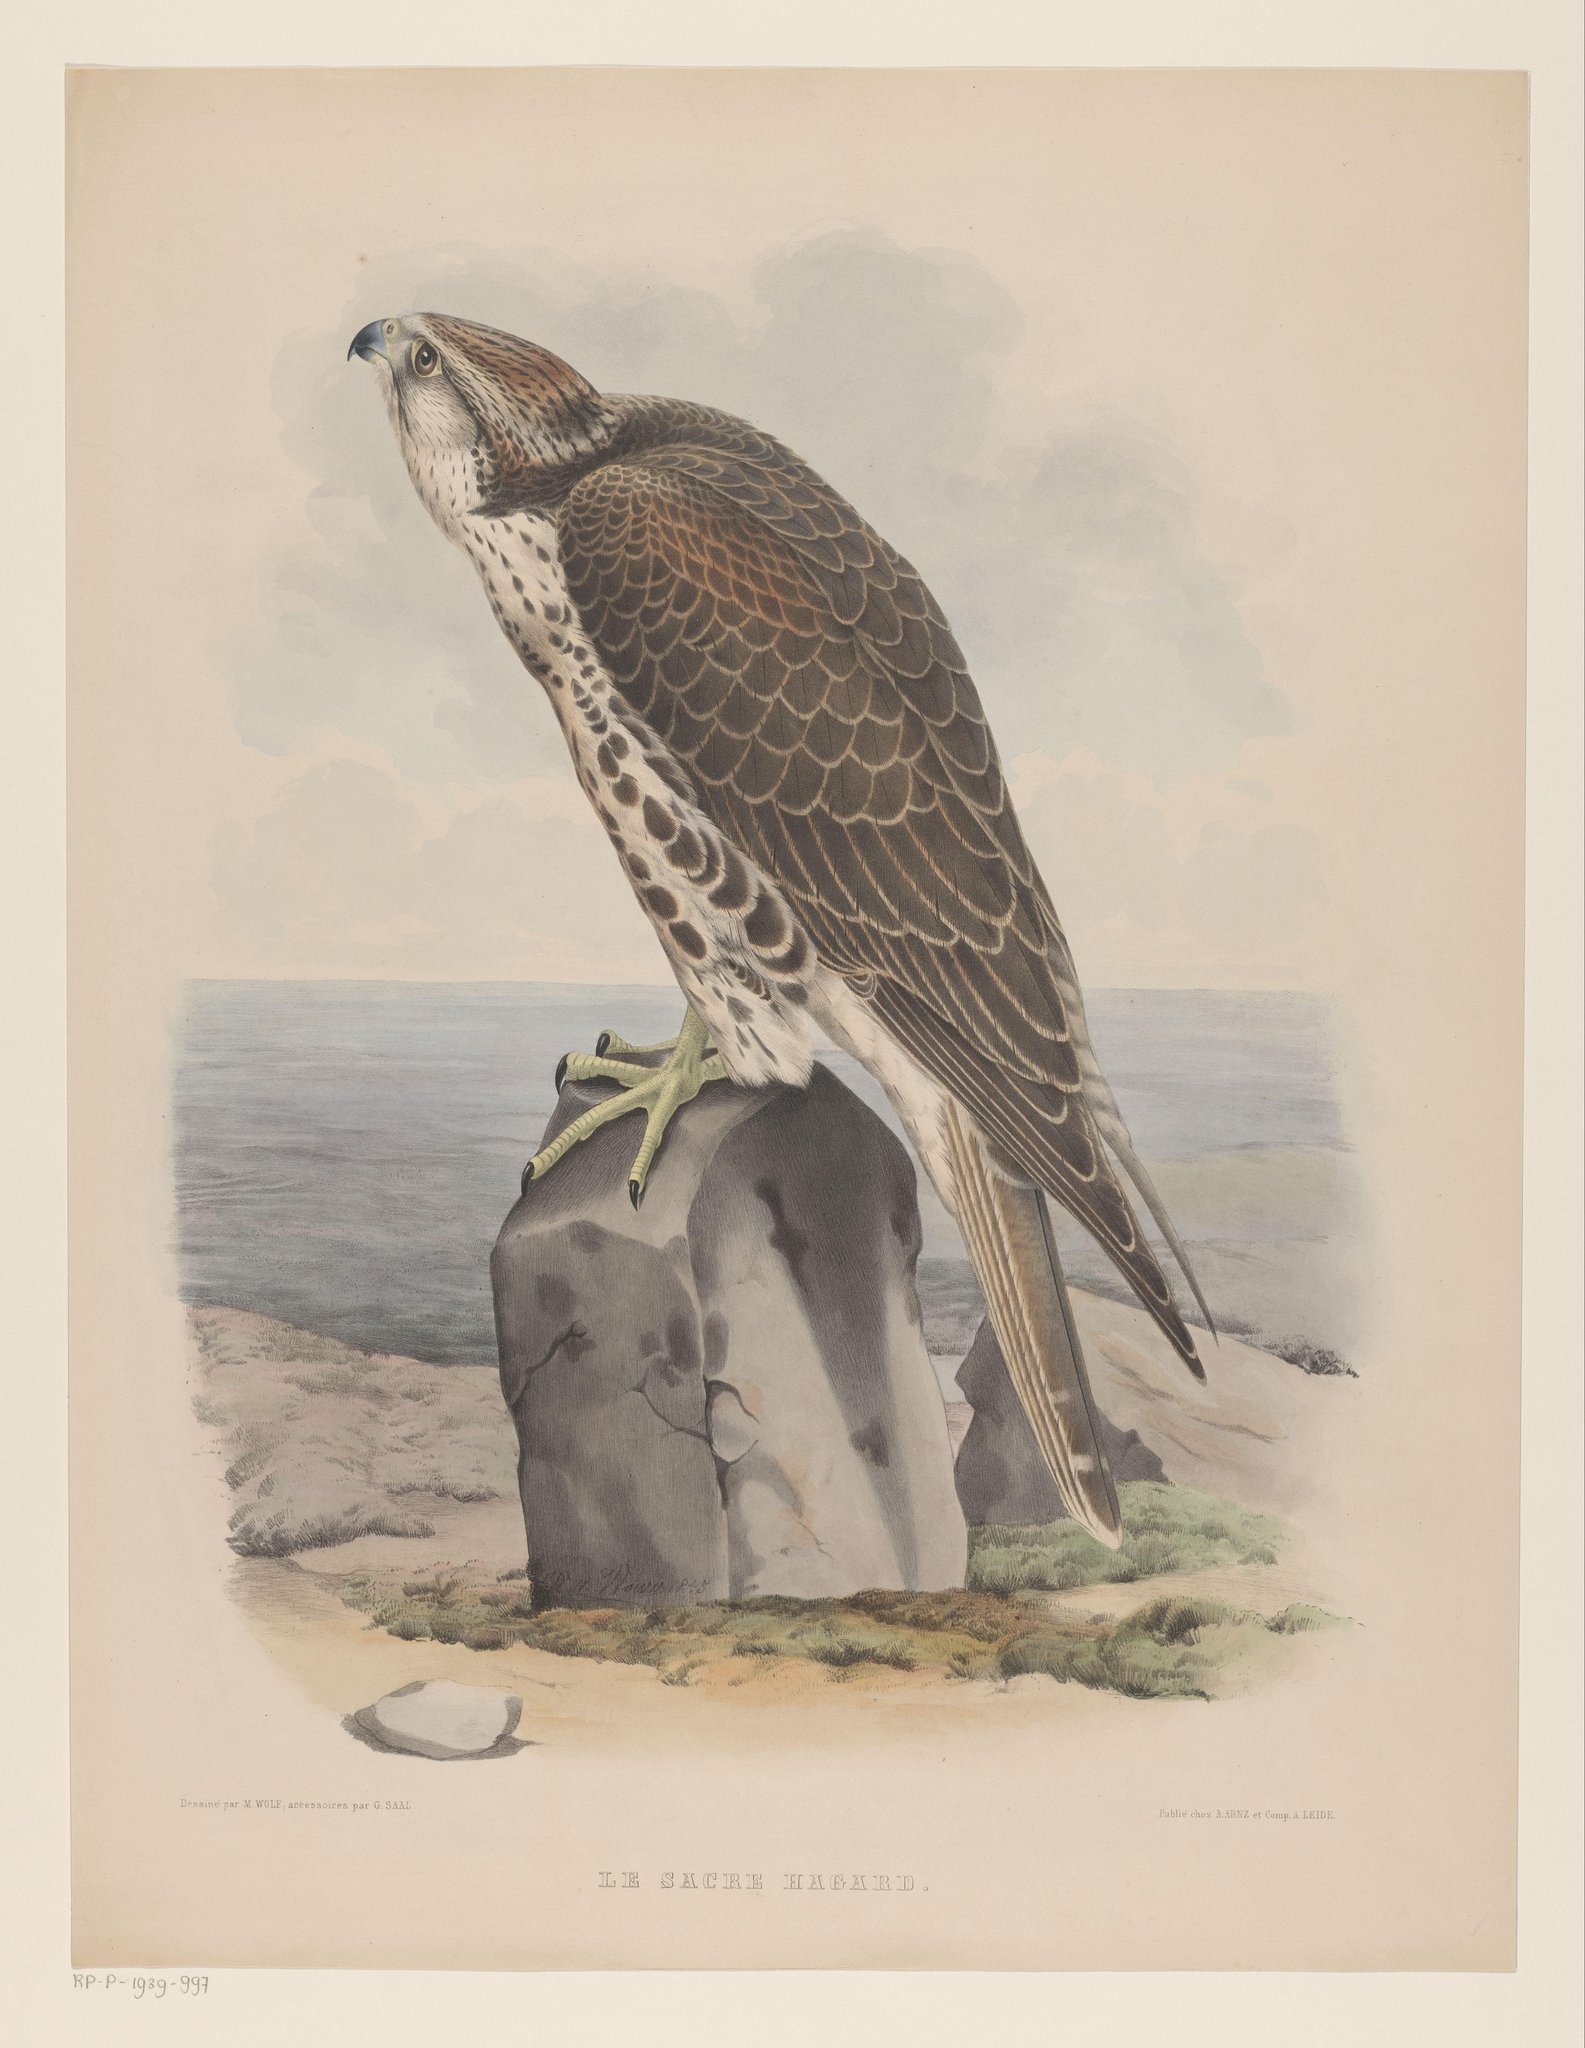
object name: book illustration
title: Le sacre hagard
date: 1843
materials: paper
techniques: lithograph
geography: leiden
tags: predatory birds: falcon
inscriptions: collector's mark: Lugt 2760, collector's mark: Lugt 2228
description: Een valk zittend op een steen met zee in de achtergrond. Een haggard (of hagerd) is een wilde vogel die bij het invangen al één of meerdere malen gemuit is.